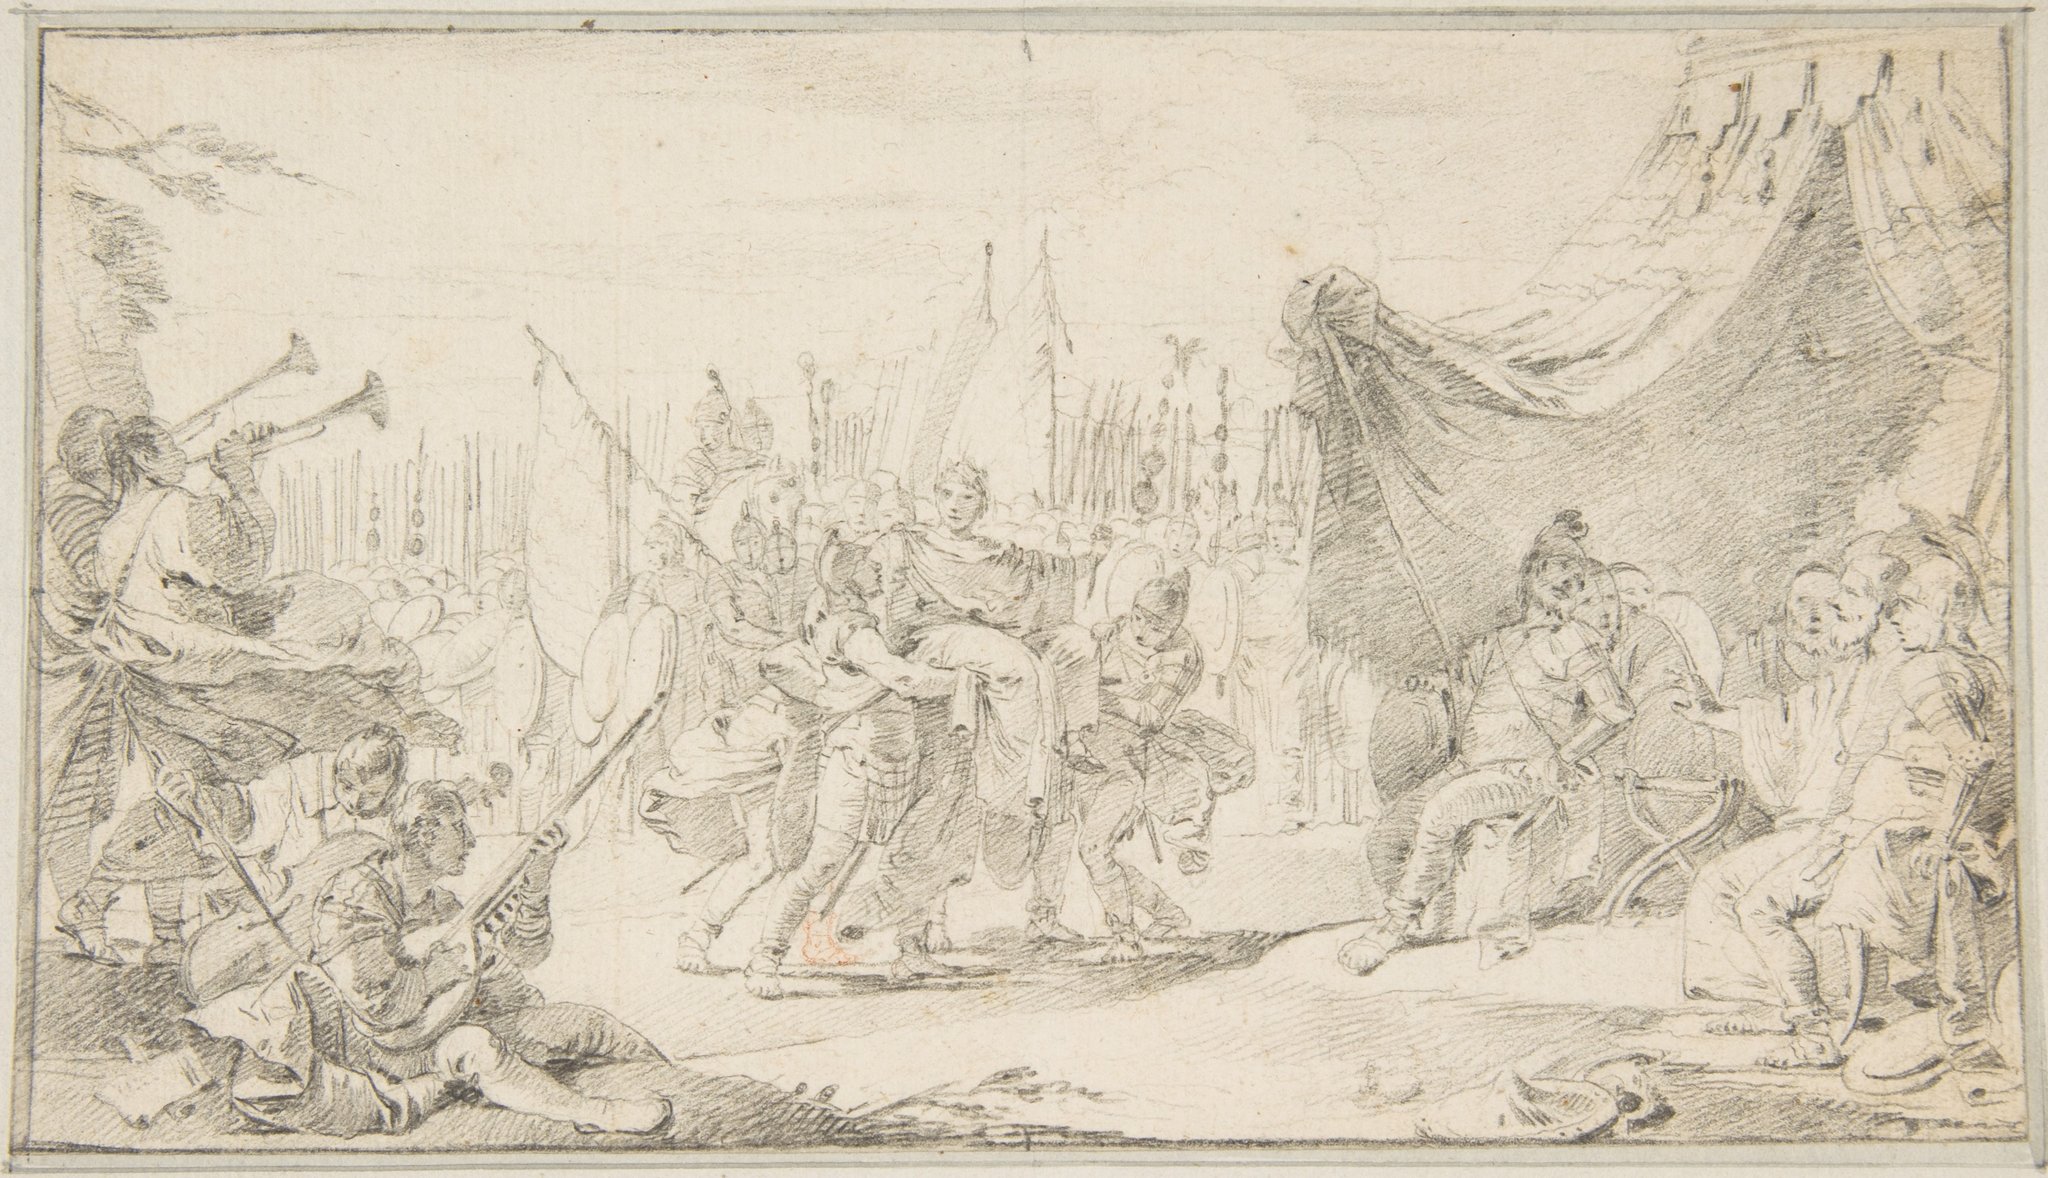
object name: drawing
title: Illustration for a Book: General Carried in Triumph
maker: giovanni battista tiepolo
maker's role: artist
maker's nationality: italian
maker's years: 1696-1770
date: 1696-1770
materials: chalk, graphite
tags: musical instruments,soldiers,men,generals,musicians